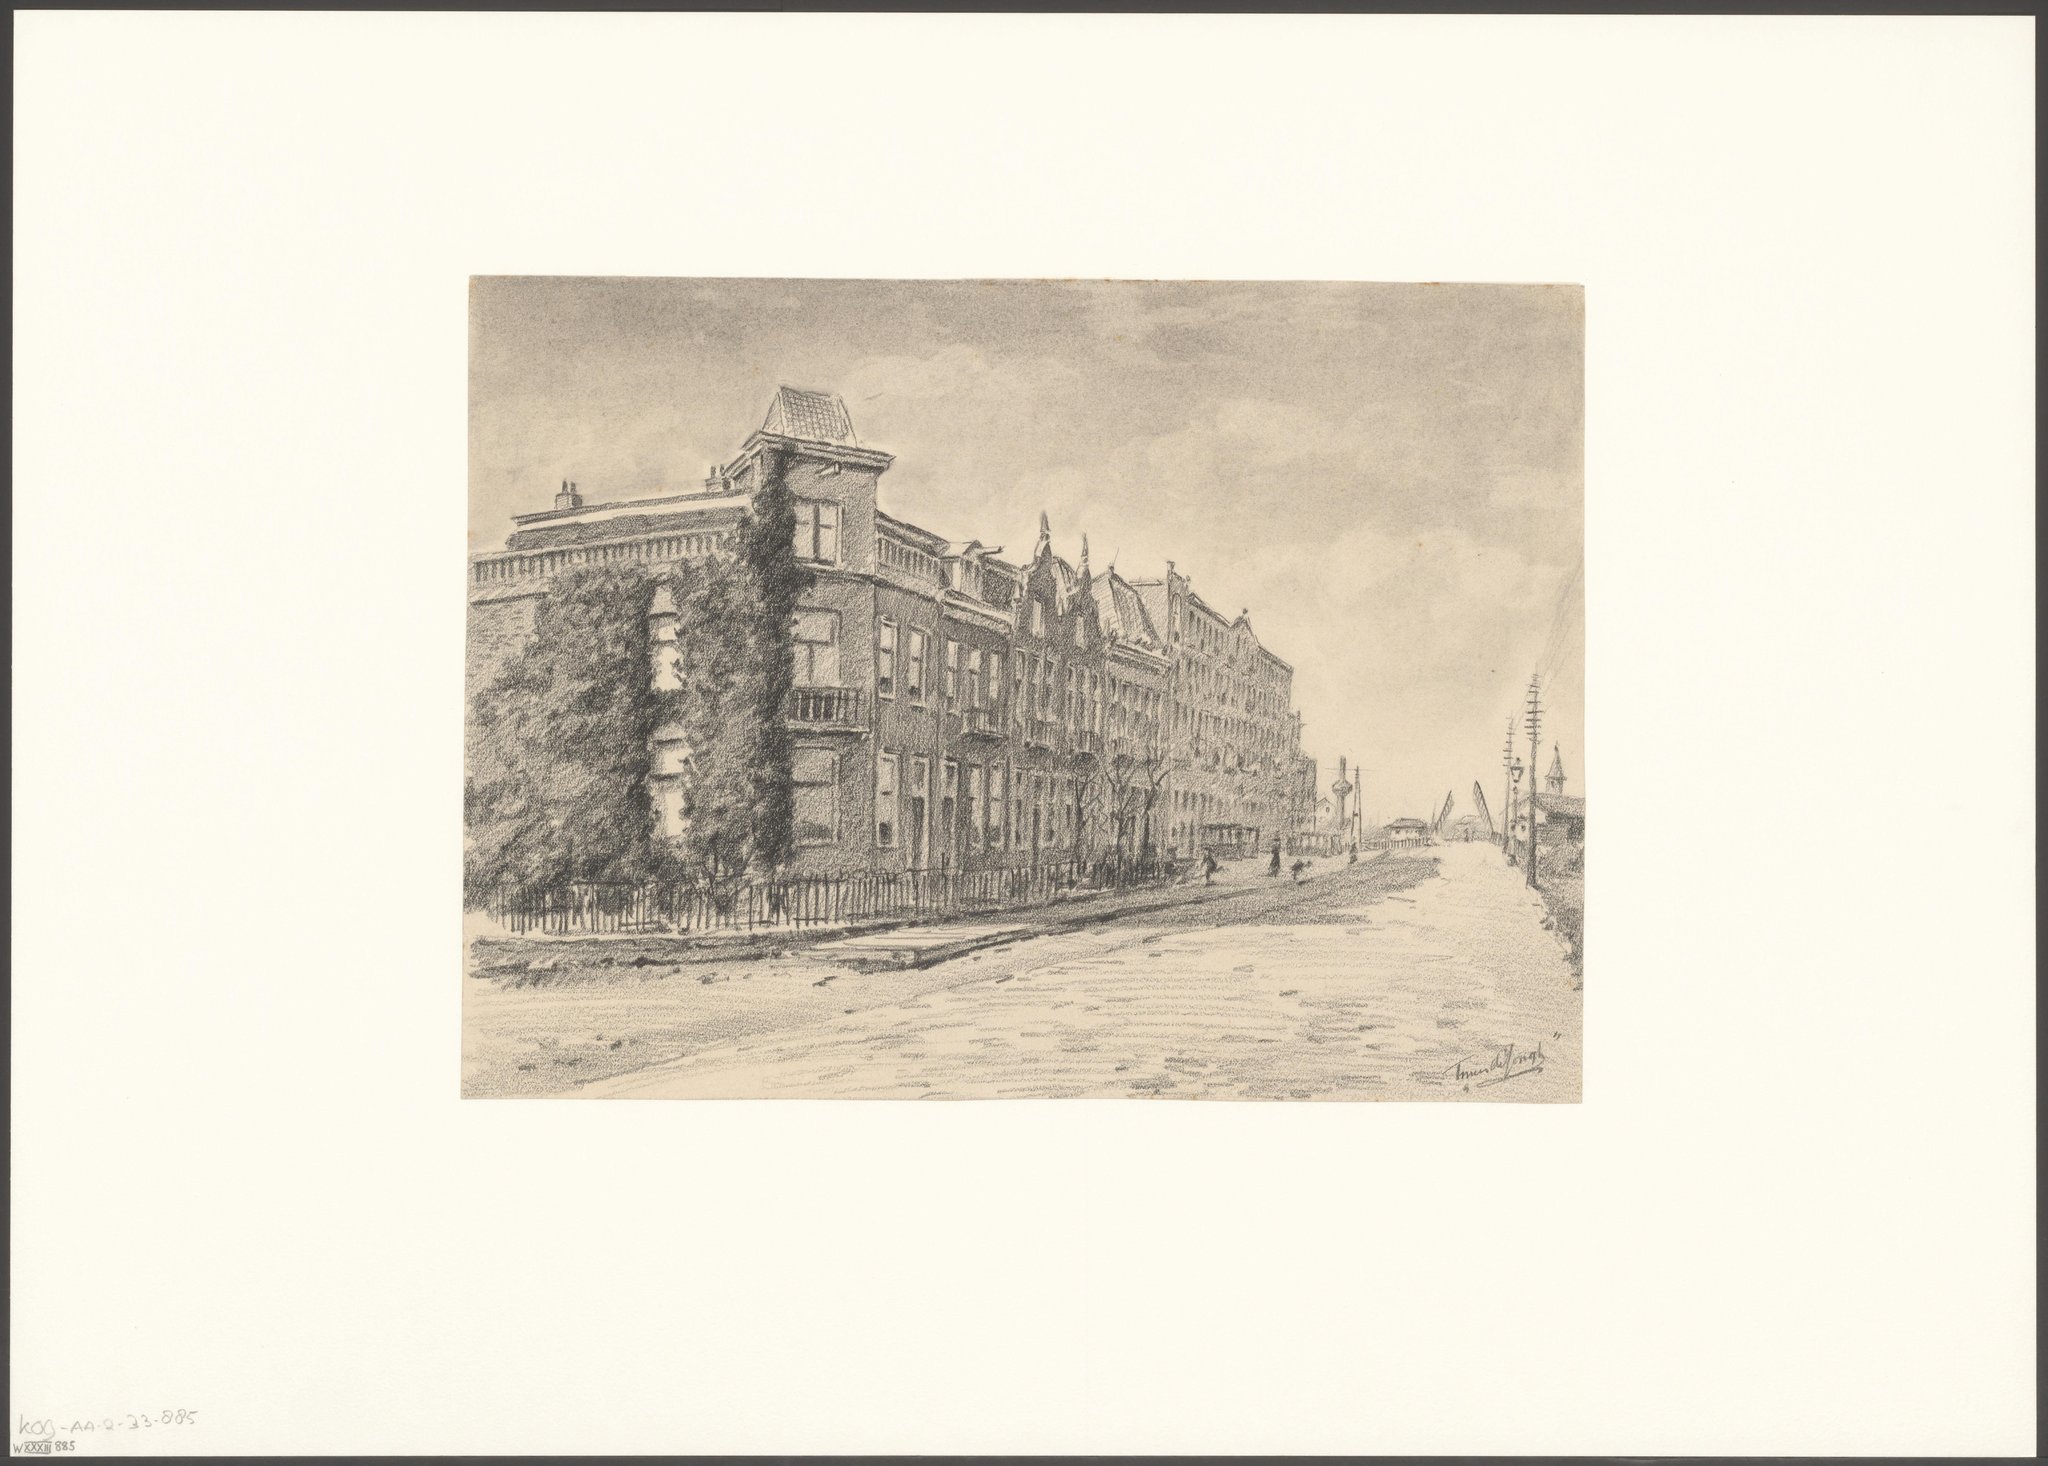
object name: drawing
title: Gezicht op de Weesperzijde met spoorwegovergang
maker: tinus de jongh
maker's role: print maker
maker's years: 1885-1942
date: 1895-1942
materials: chalk, paper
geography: amsterdam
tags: city-view in general; 'veduta', road, path, railway, train, the usual house or row of houses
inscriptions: inscription: ‘afbraak bestemd veel (...) [...] met overweg.’, signature: ‘"TinusdeJongh"’, signature and date: ‘TinusdeJongh’, collector's mark: Lugt 800a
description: Tekening binnen de Atlas Van Eck ingedeeld op wijknummer 33.